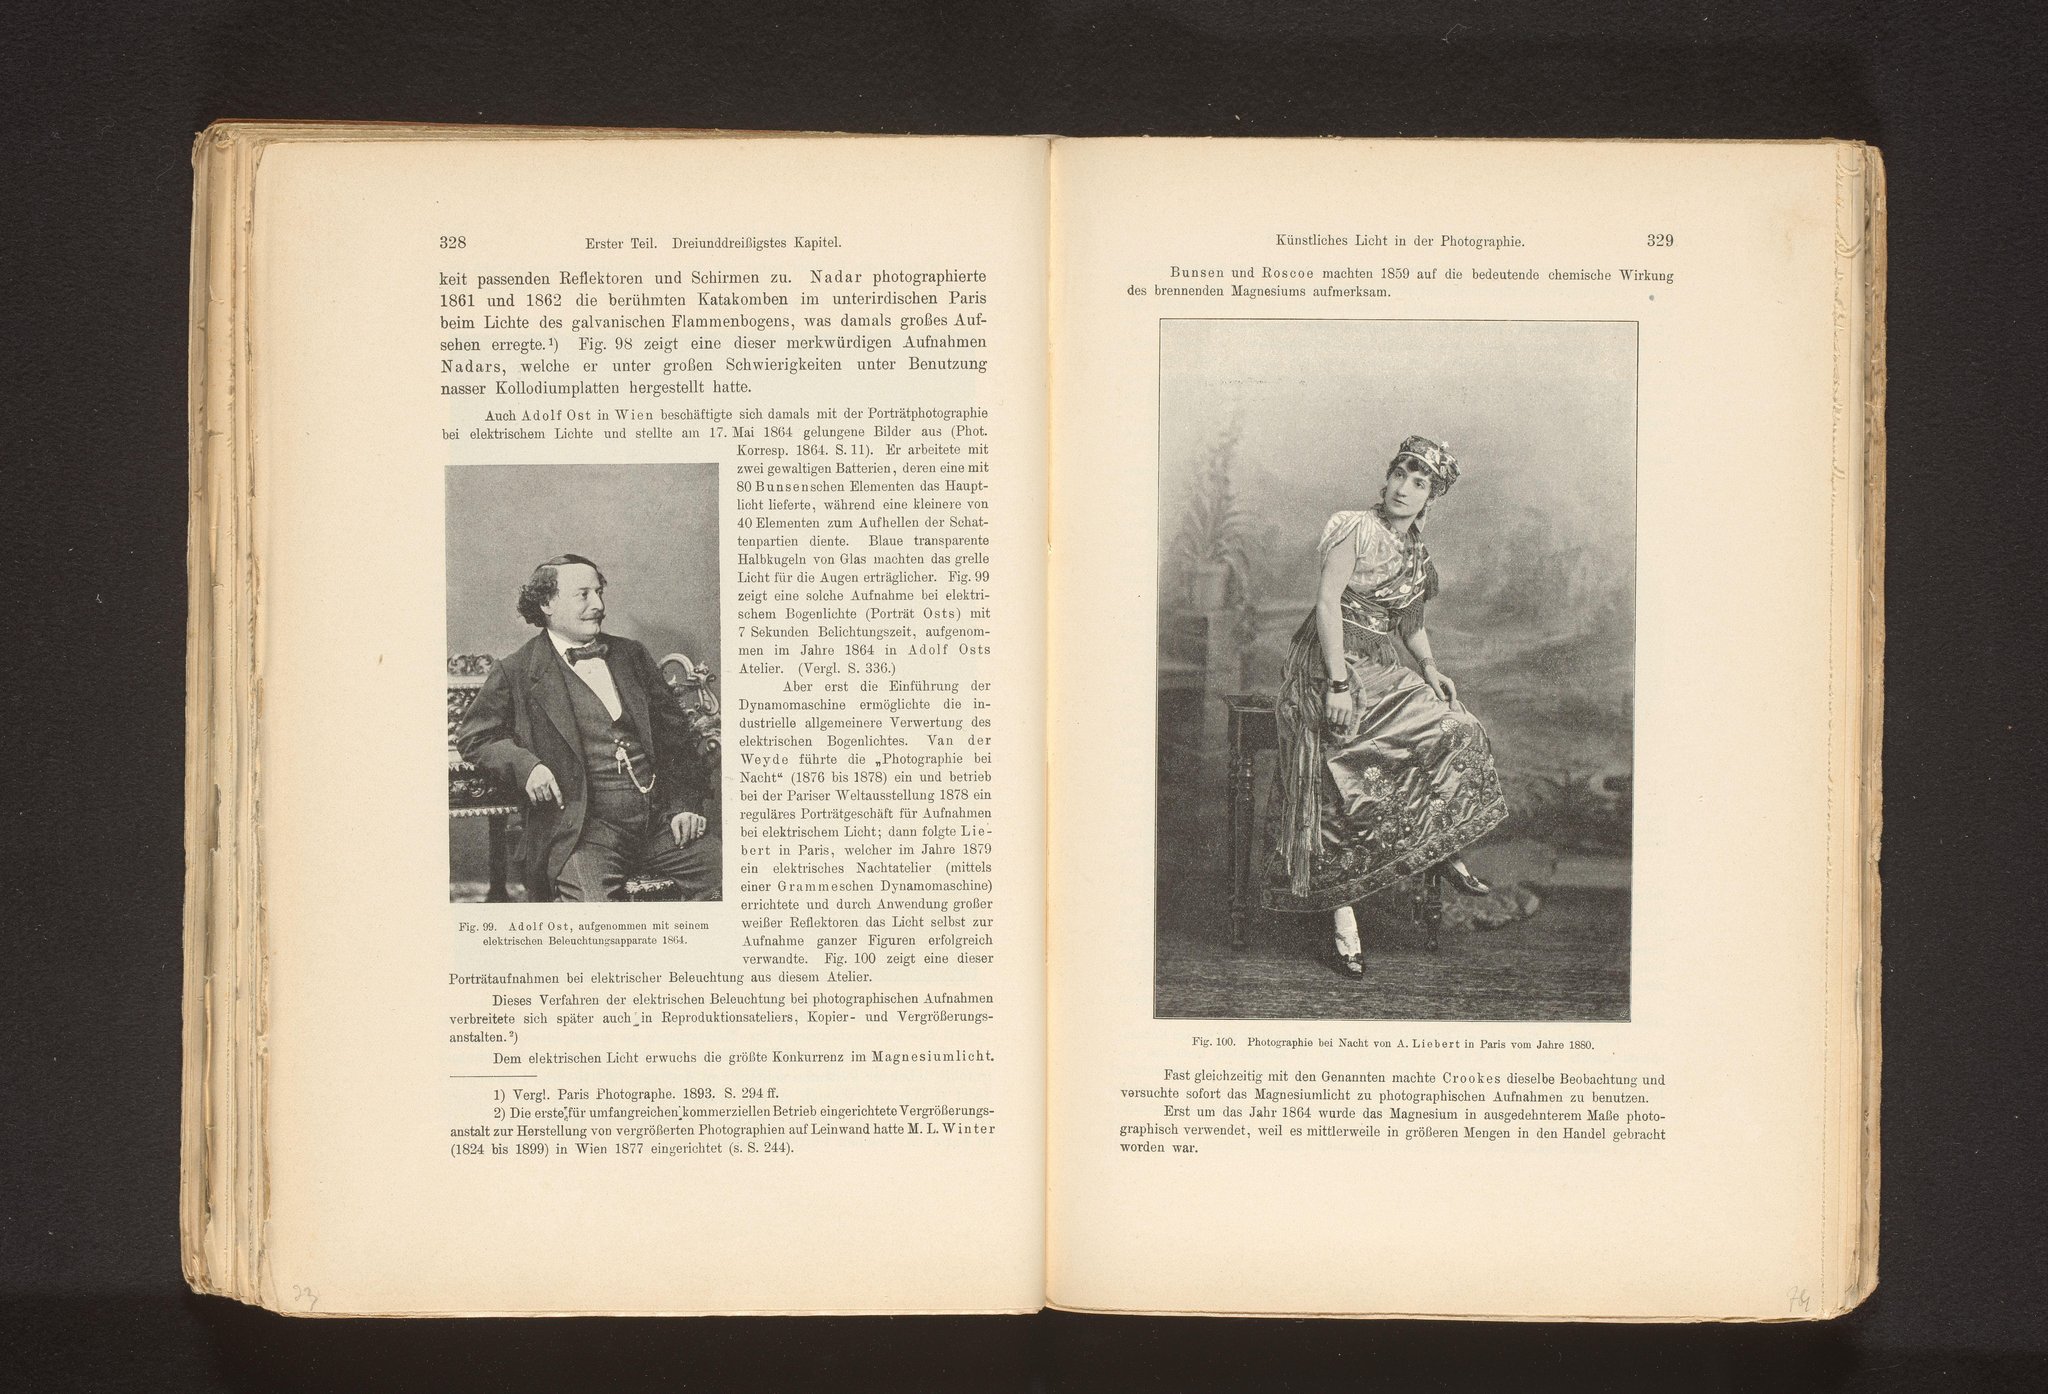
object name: photomechanical print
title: Portret van Adolf Ost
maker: Anonymous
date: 1900-1905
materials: paper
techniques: autotype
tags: portrait, self-portrait of photographer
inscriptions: number: ‘Fig. 99.’